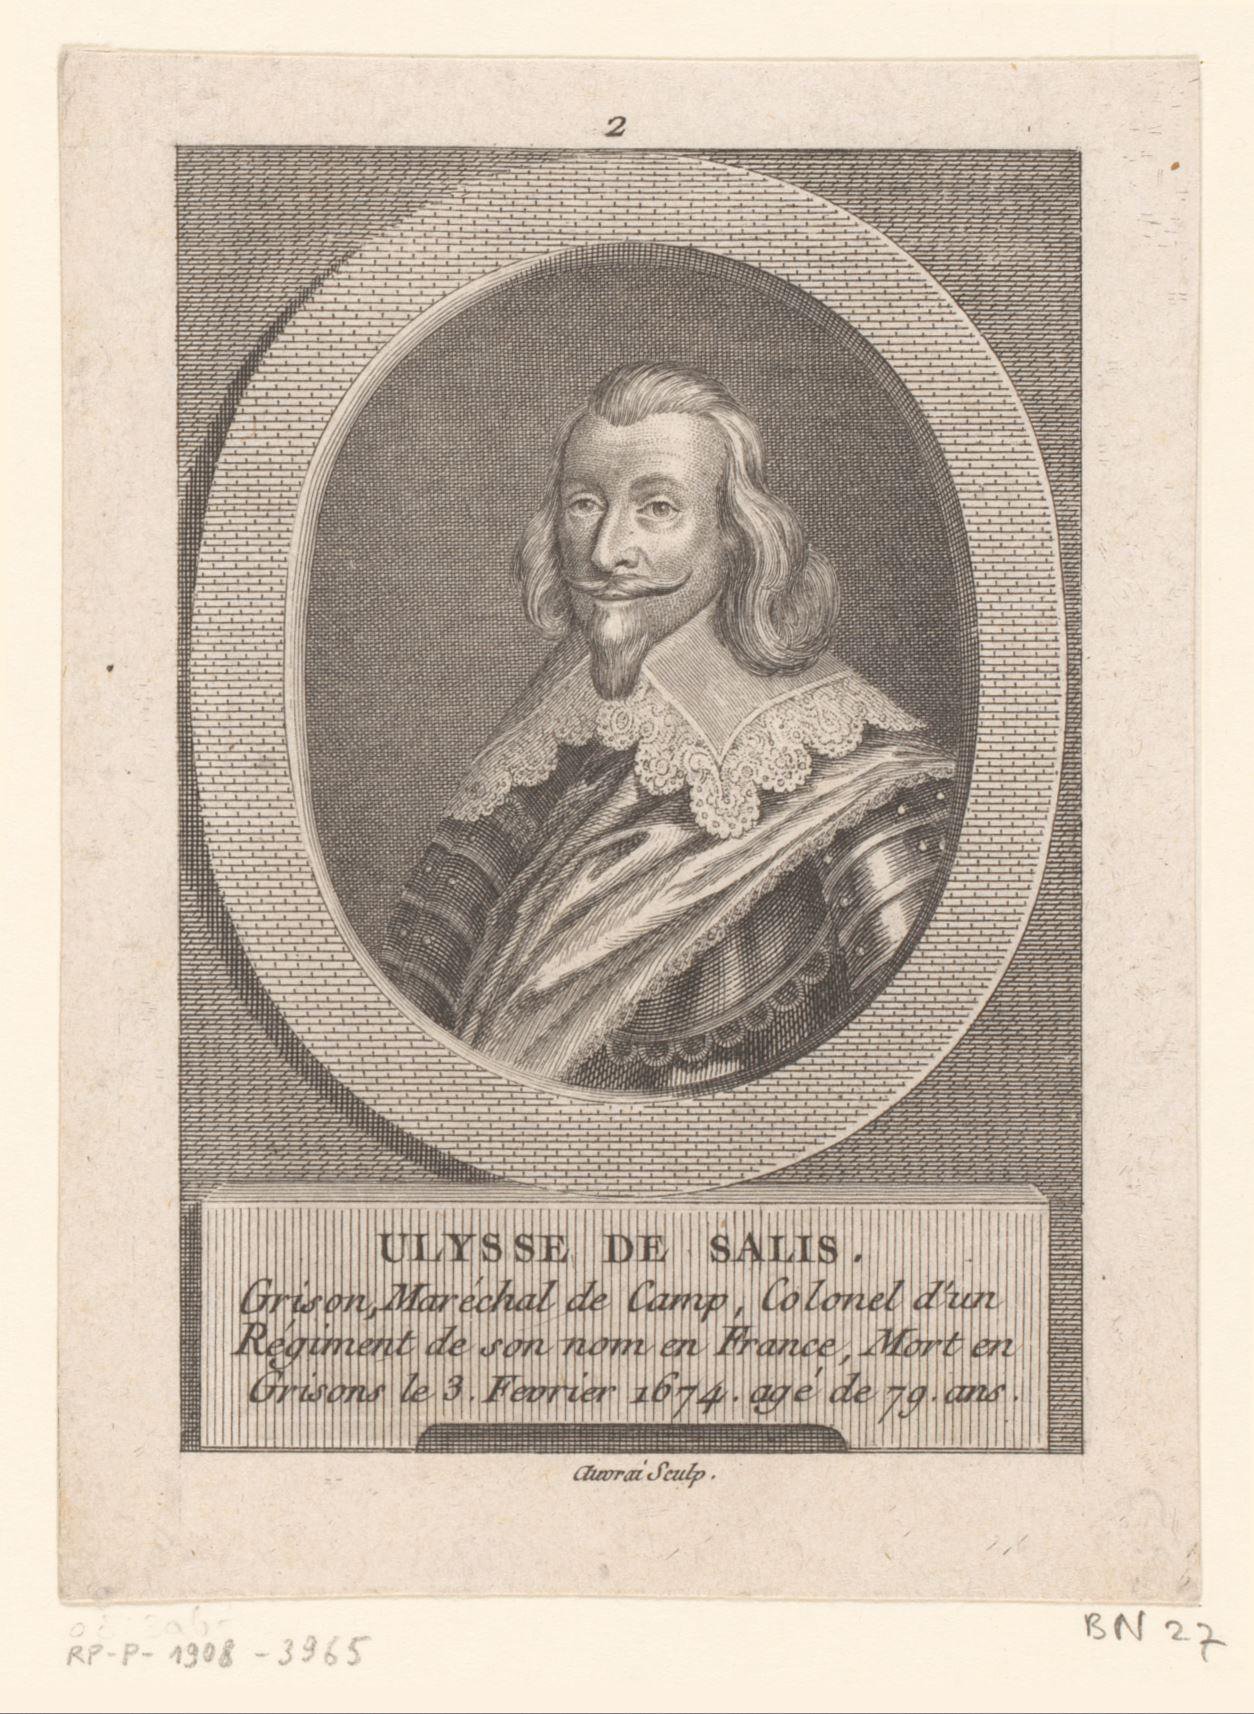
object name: print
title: Portret van Ulysses von Salis-Marschlins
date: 1784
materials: paper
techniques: engraving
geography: paris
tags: politician, ornament ~ medallion, historical persons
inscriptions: collector's mark: Lugt 2228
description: Prent uit: De la Borde, Jean Benjamin. Tableaux de la Suisse, ou voyage pittoresque fait dans les xiii cantons du corps helvétique. Parijs: Pierre-Michel Lamy, 1784.